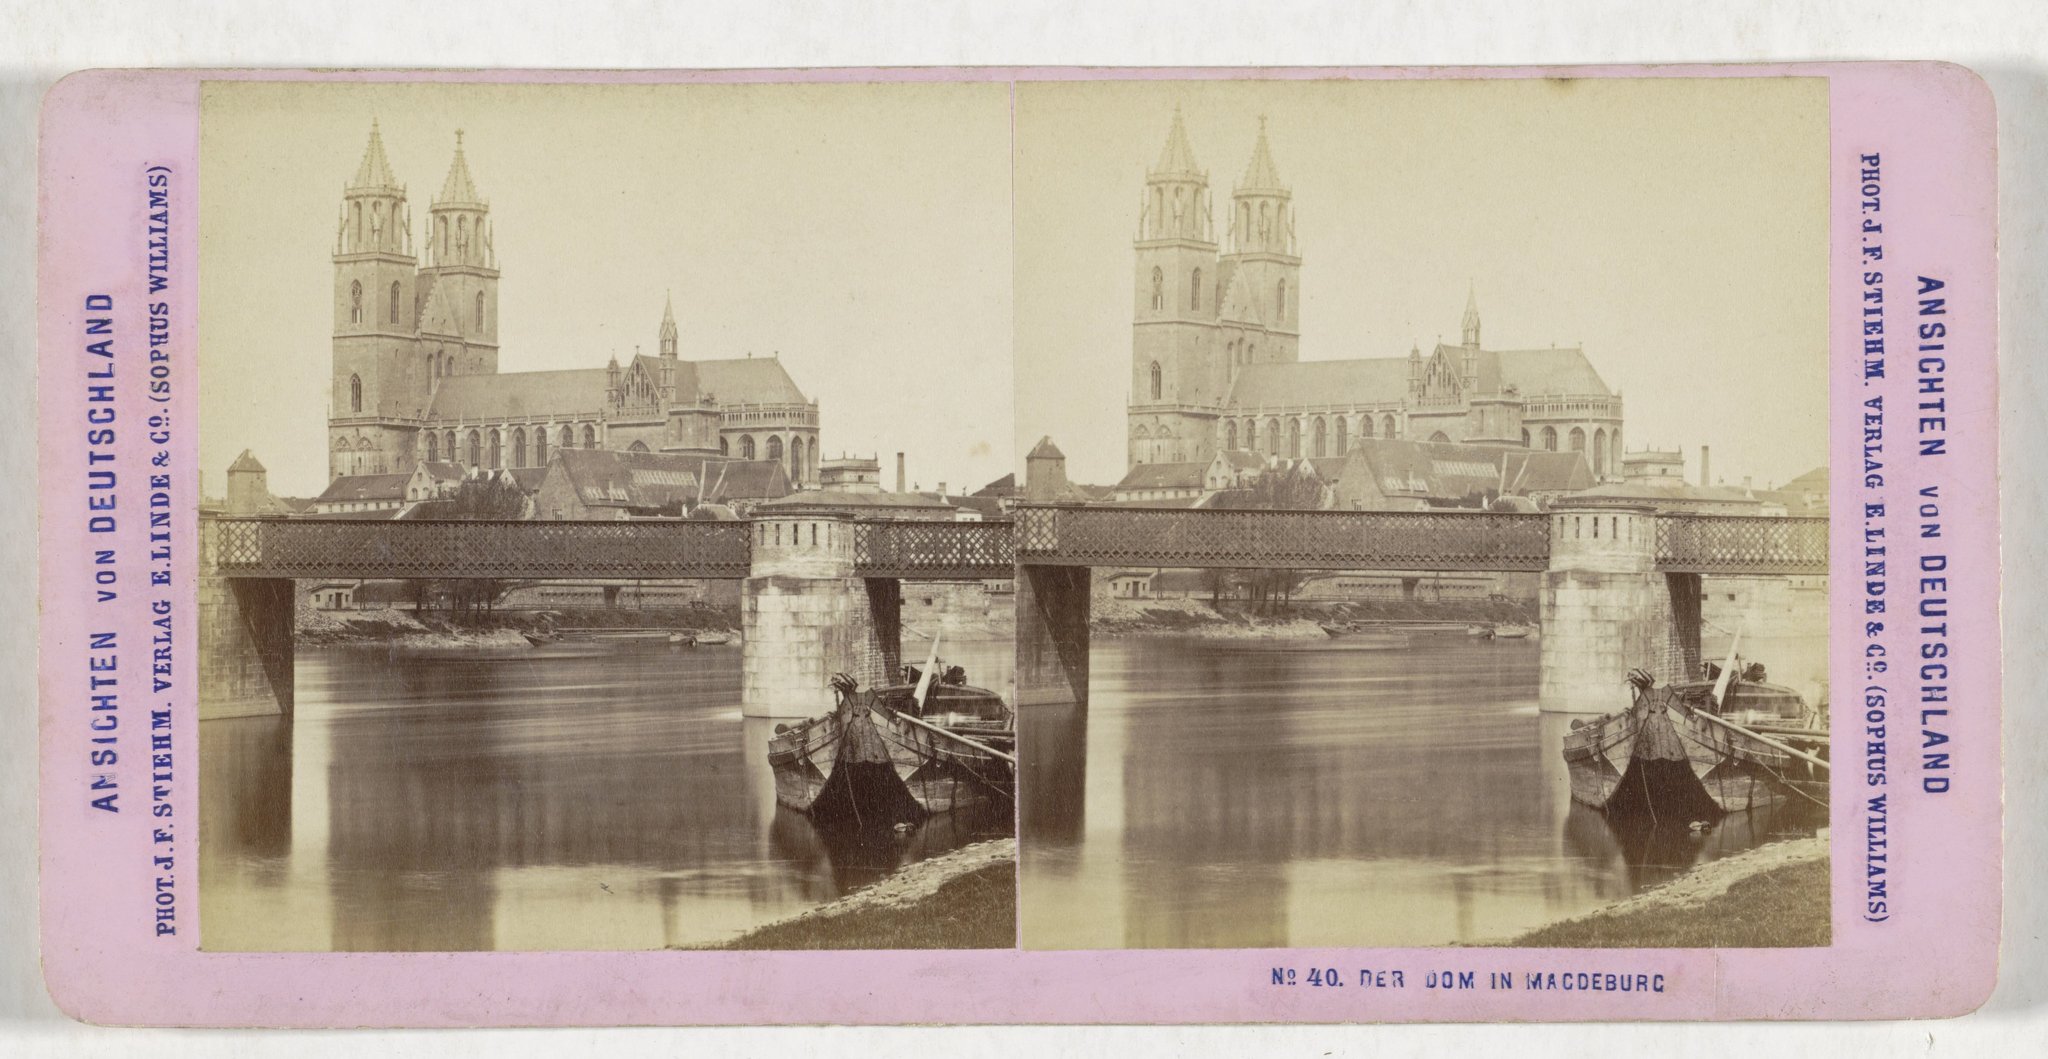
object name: stereograph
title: Dom van Maagdenburg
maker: johann friedrich stiehm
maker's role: fotograaf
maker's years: 1826-1902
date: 1869-1872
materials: cardboard, paper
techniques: albumen print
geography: berlin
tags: river, church (exterior), bridge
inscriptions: number: ‘No 40.’